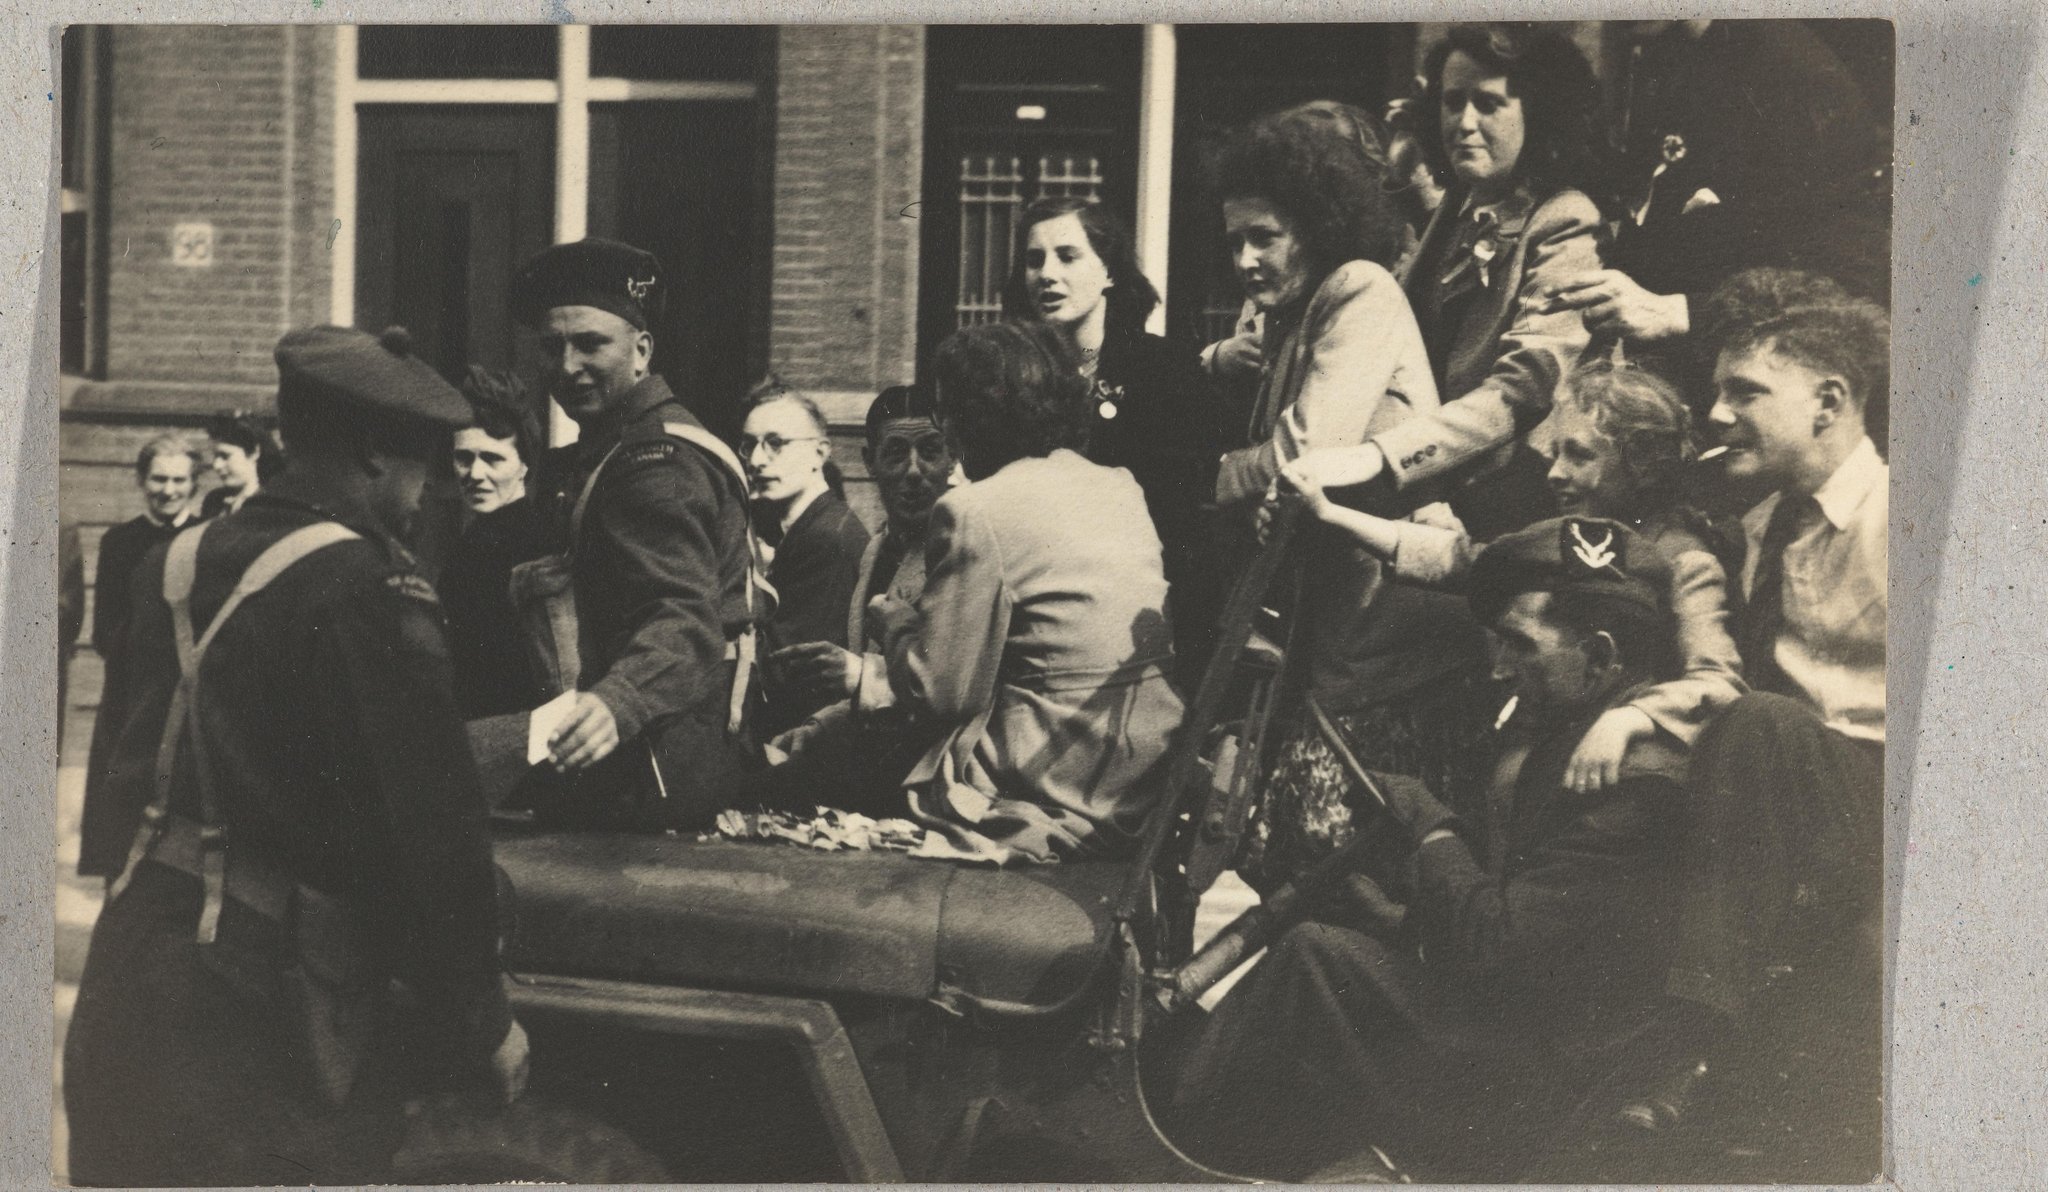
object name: photograph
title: Bevrijding van Amsterdam in mei 1945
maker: Anonymous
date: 1945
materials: paper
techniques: gelatin silver print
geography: amsterdam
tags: festivities, amsterdam